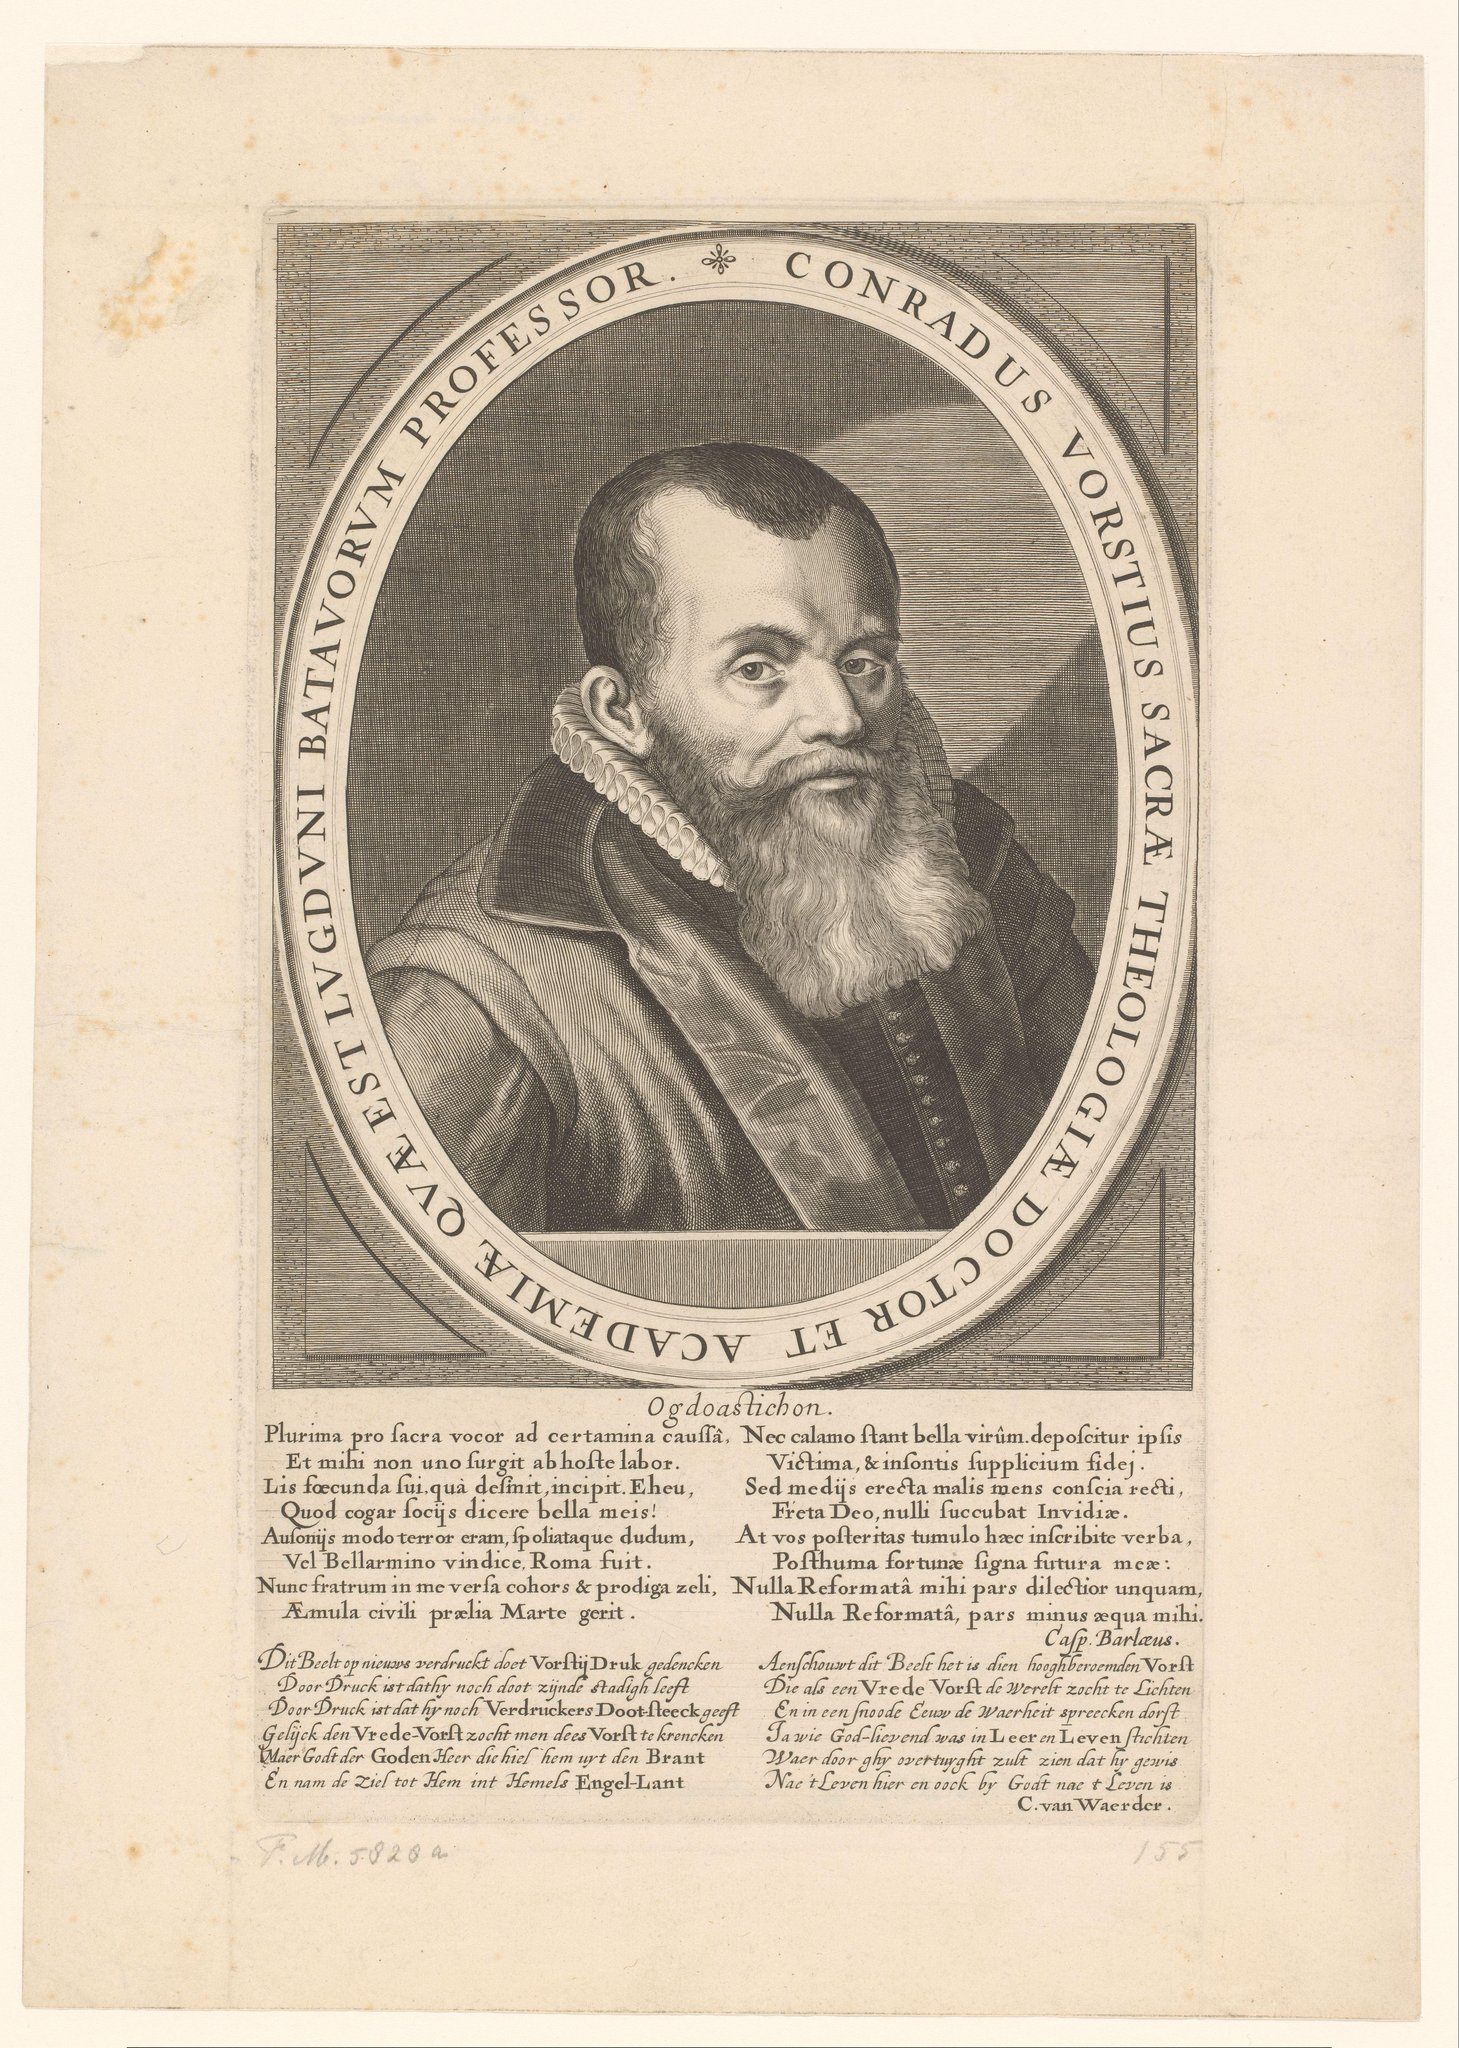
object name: print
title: Portret van Conradus Vorstius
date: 1600-1650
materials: paper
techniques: engraving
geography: netherlands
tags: cologne, theologian, historical persons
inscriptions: collector's mark: Lugt 2228, collector's mark: Lugt 240